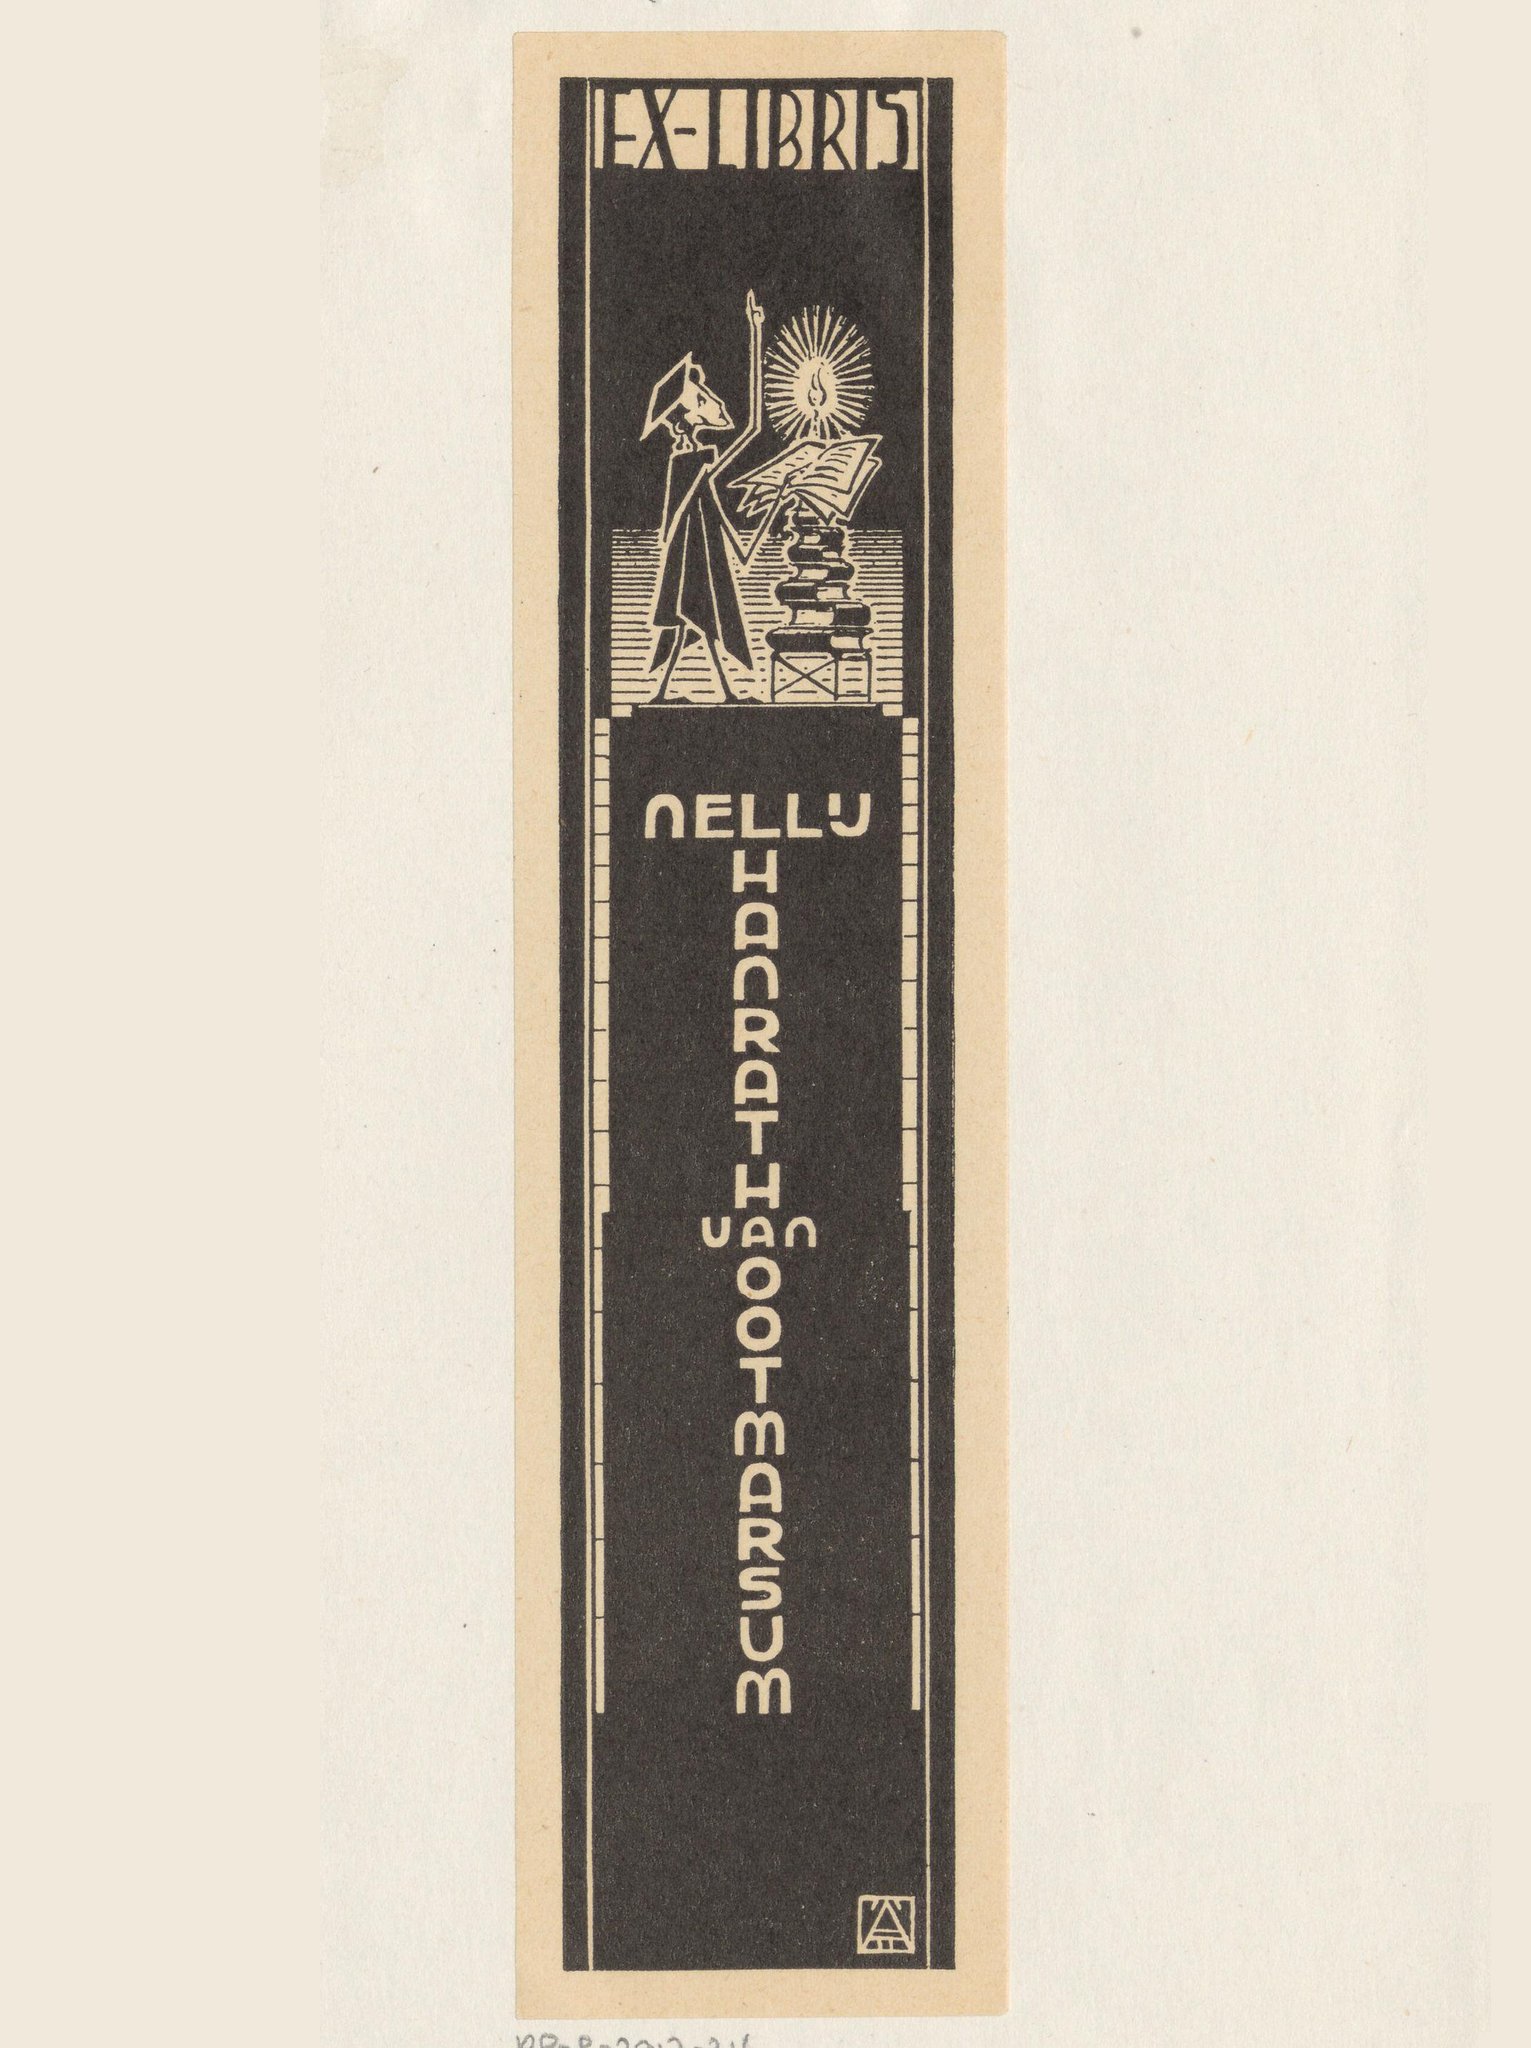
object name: bookplate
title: Ex libris van Nelly Hanrath-van Ootmarsum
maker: constant joseph alban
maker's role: painter, print maker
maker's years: 1873-1944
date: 1932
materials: paper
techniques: printing block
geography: netherlands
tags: scholar in his study, candle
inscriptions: signature: ‘C.J. Alban / Cl. 32’